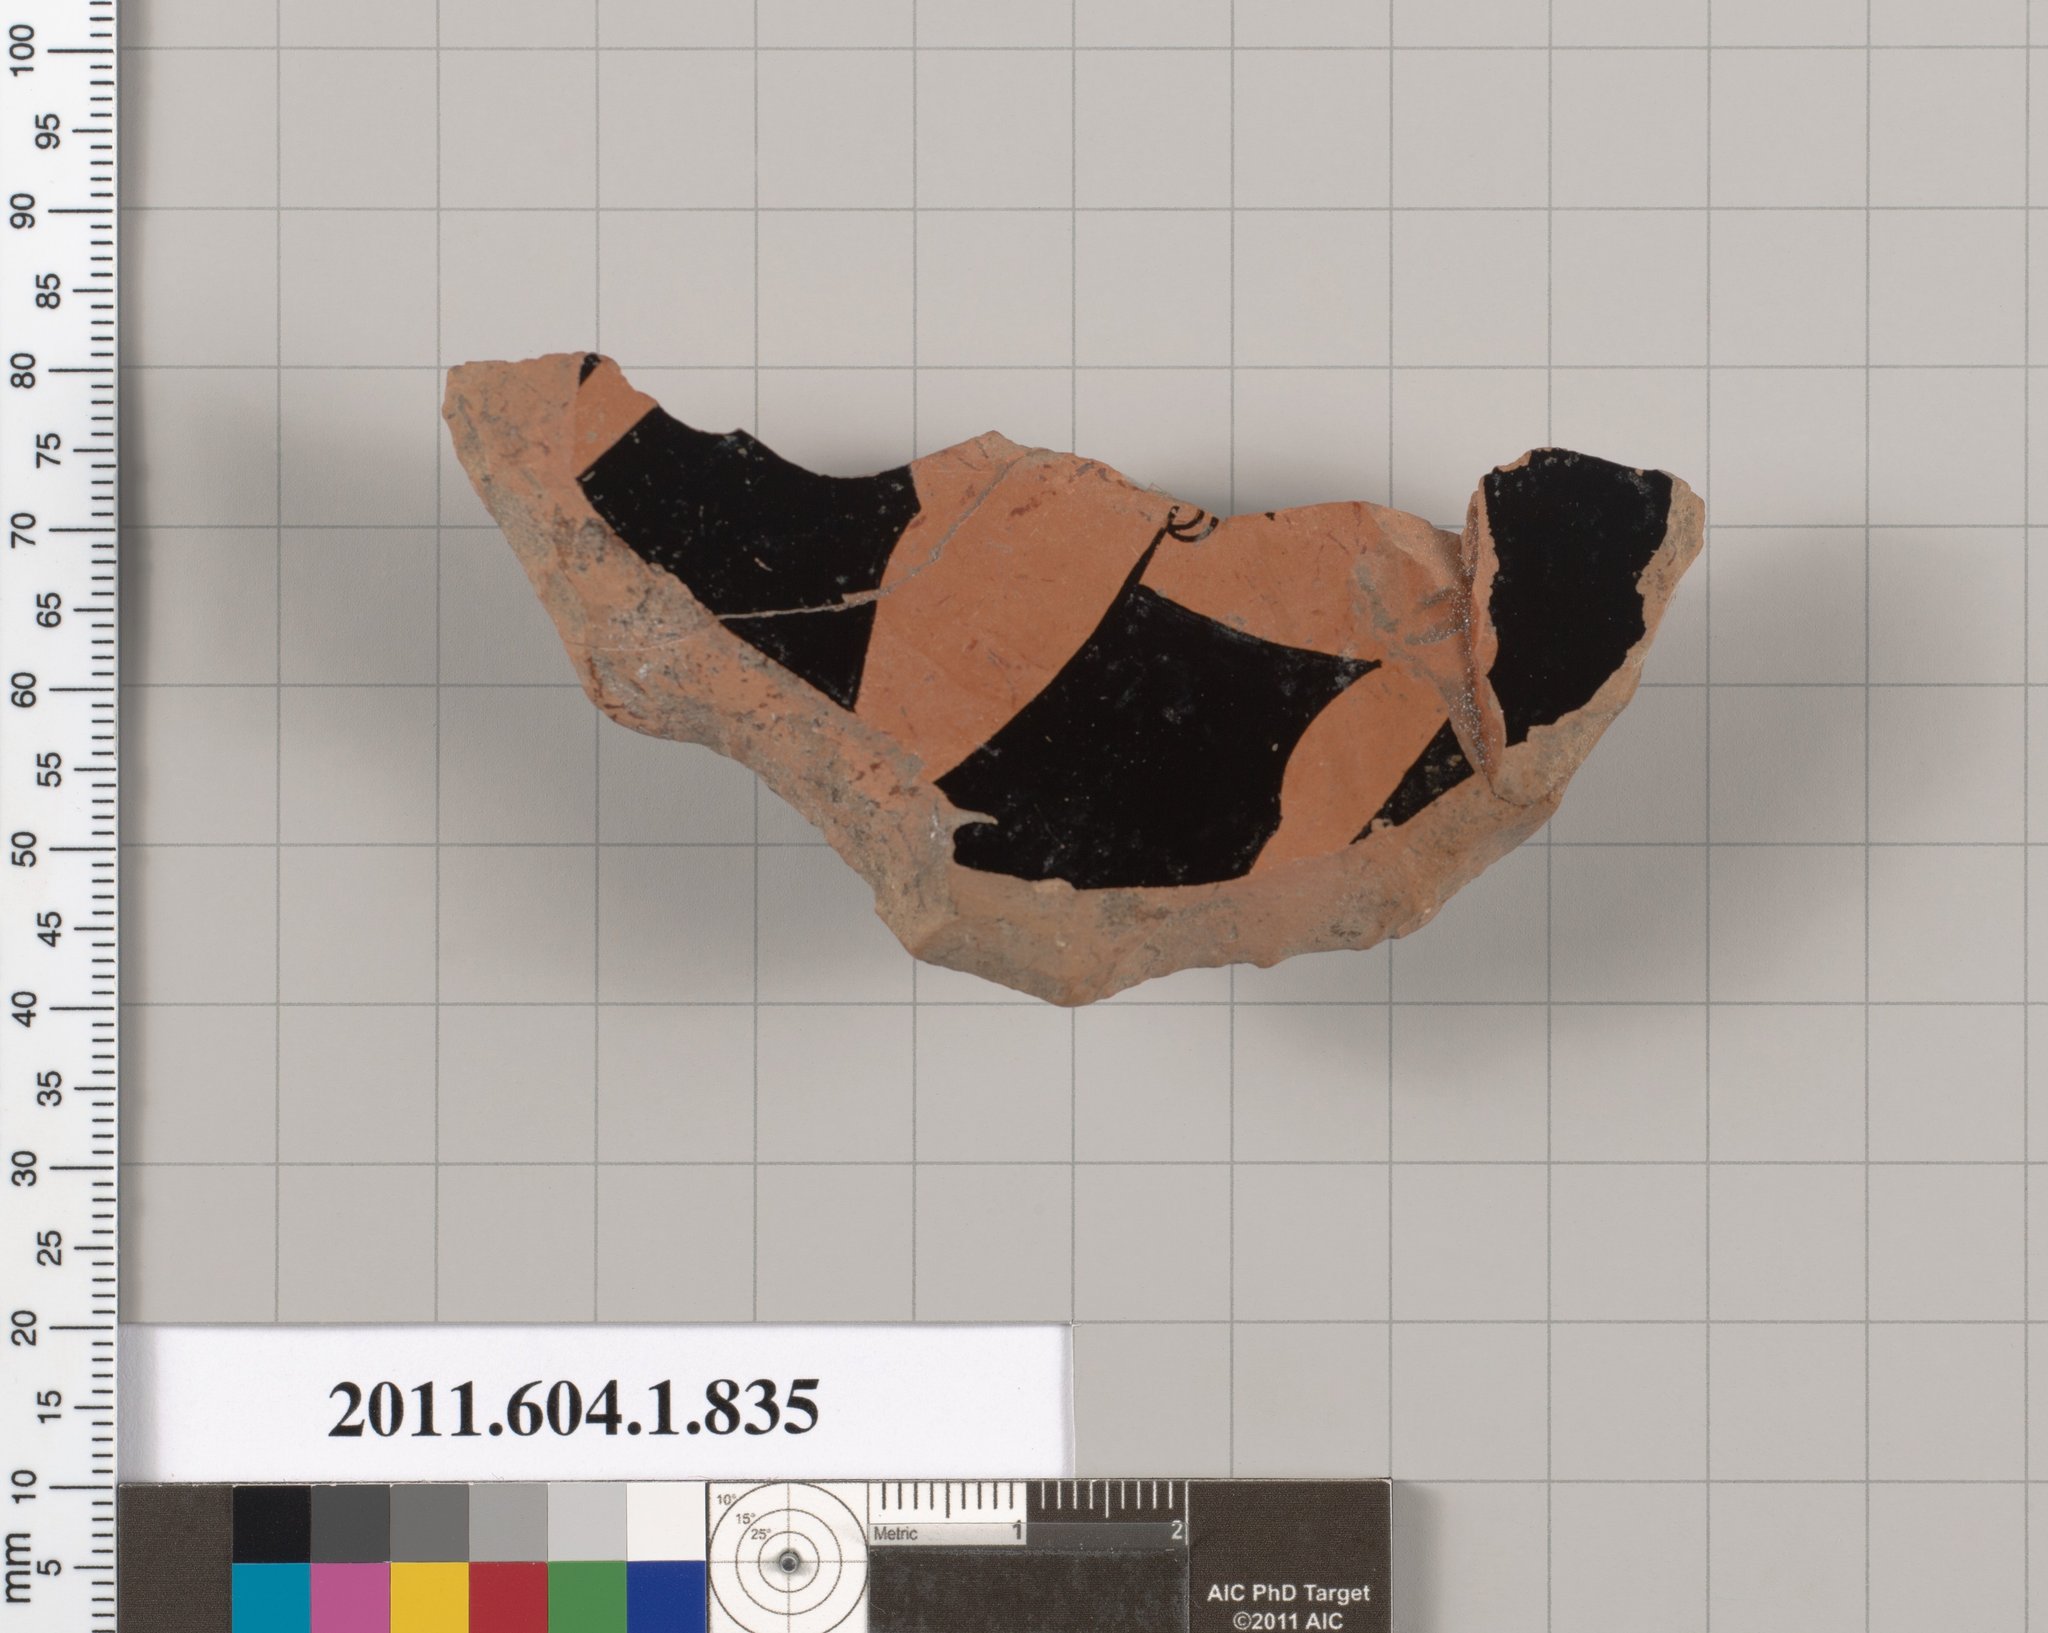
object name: kylix fragment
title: Terracotta fragment of a kylix (drinking cup)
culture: greek, attic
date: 475-451 BCE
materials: terracotta